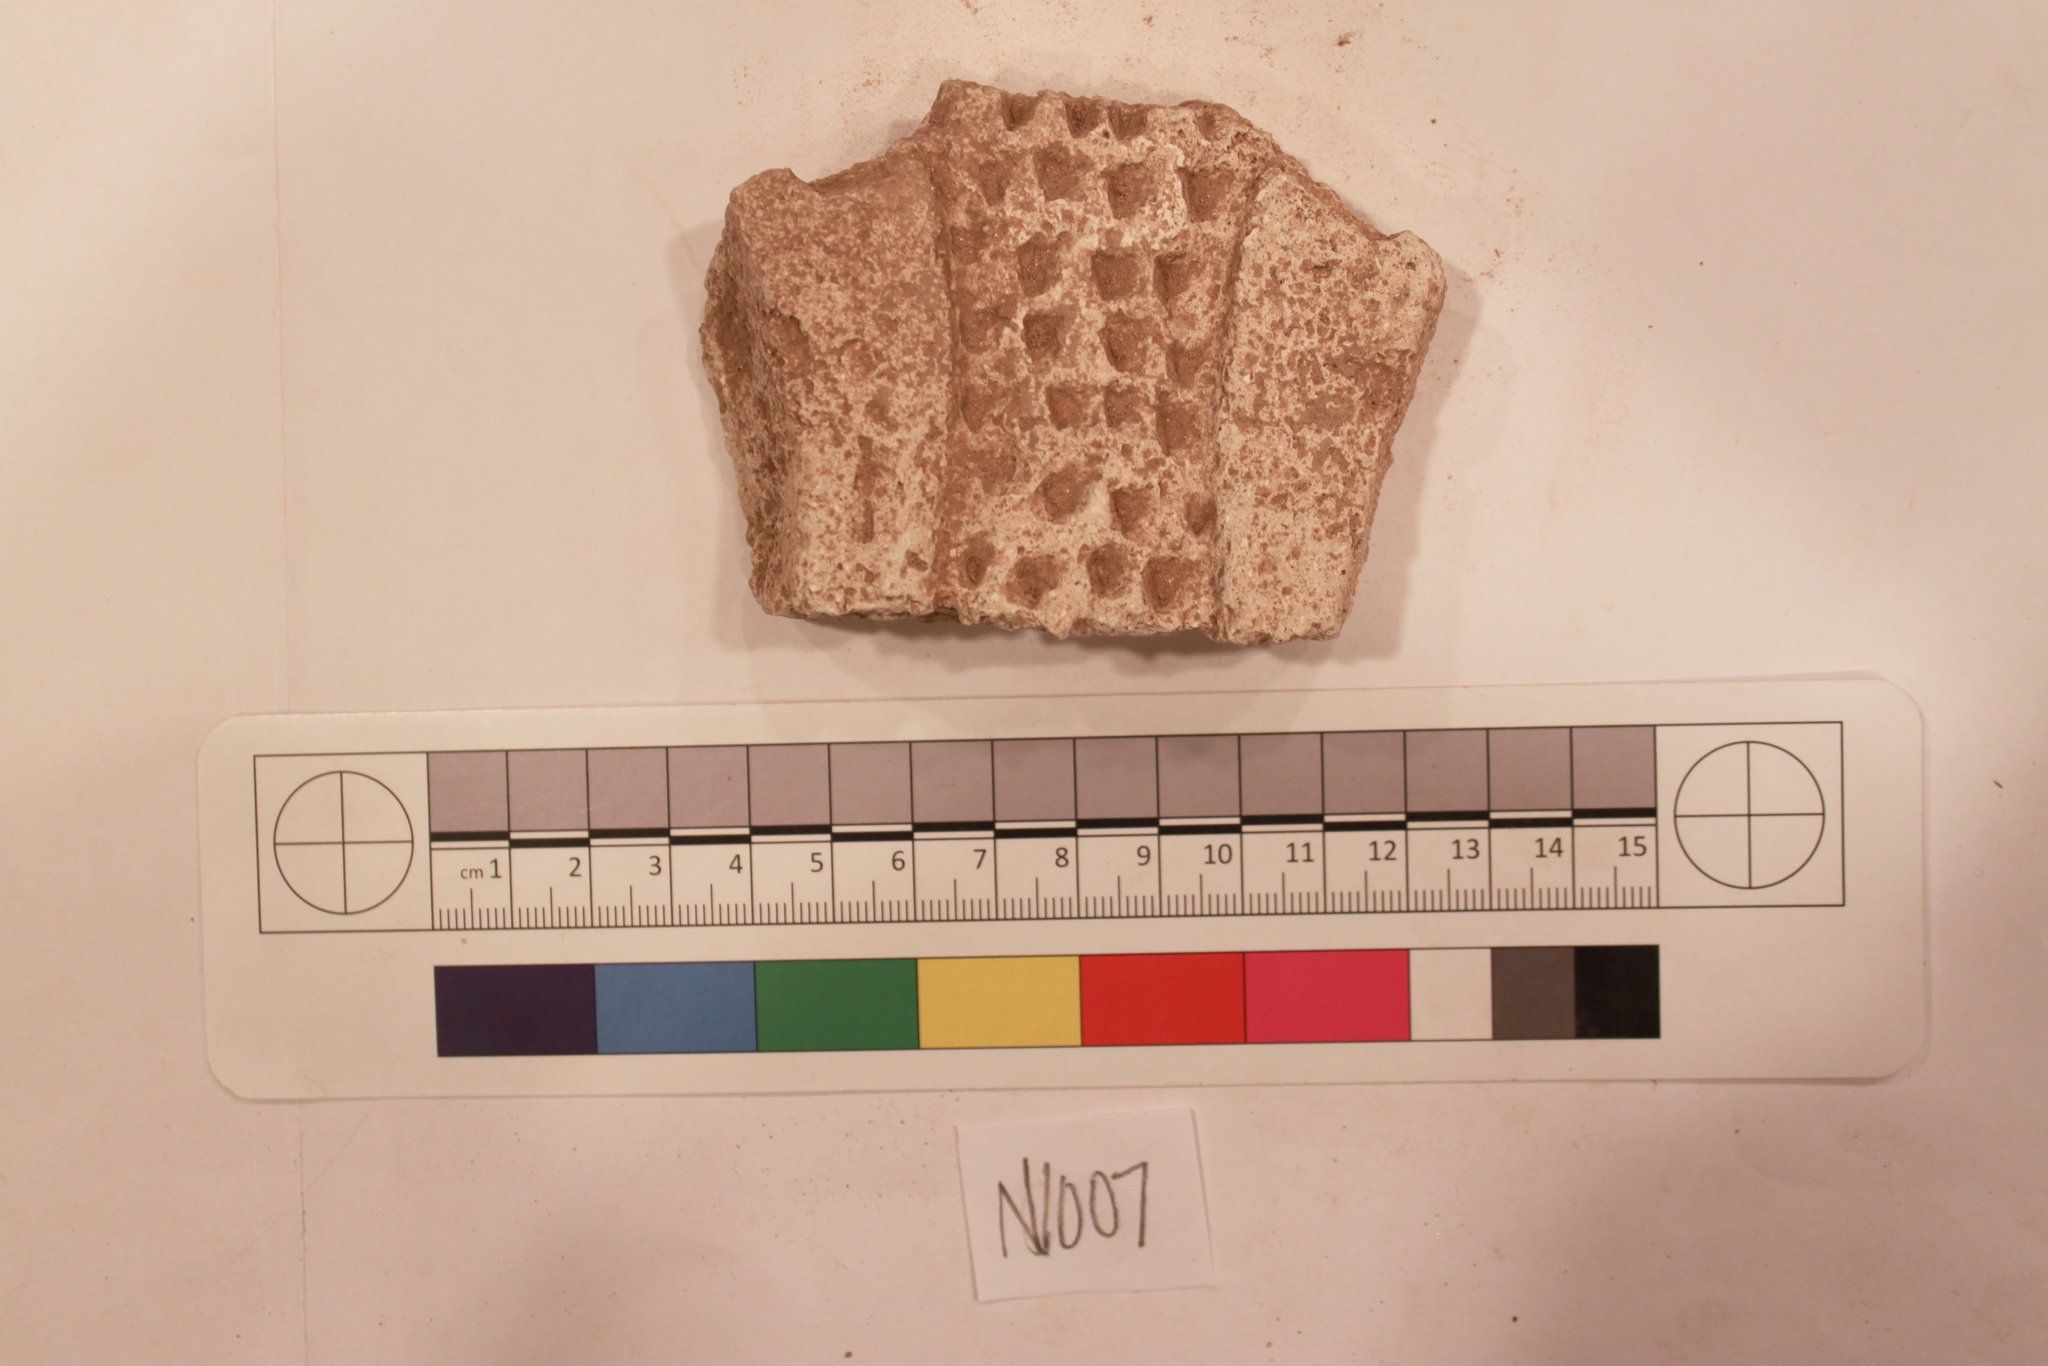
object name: fragment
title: Stucco Fragment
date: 701-1200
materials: plaster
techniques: carving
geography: iran